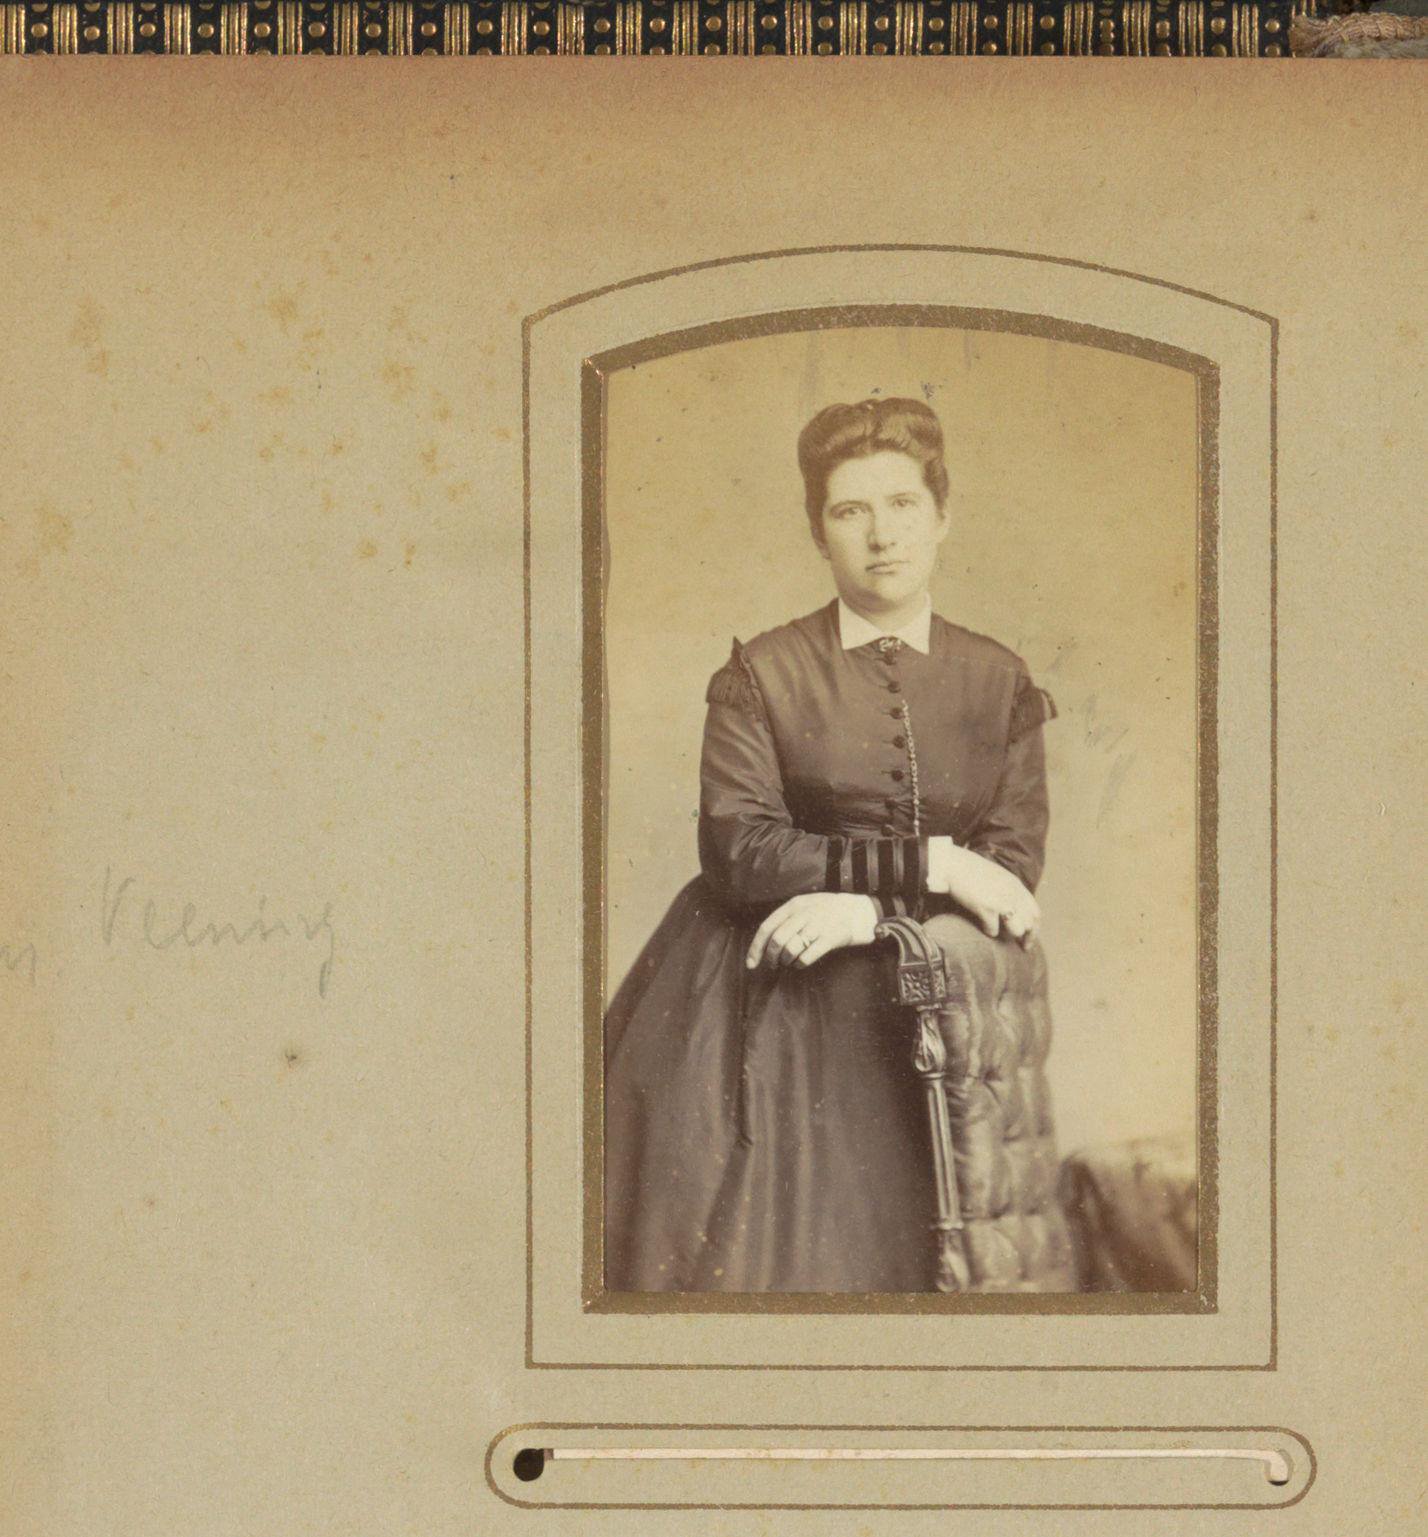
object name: photograph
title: Portret van een vrouw, [(...)] Veening geheten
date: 1865-1880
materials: cardboard, paper, photographic support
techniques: albumen print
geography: netherlands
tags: adult woman, studio requisites ~ photographer, historical persons - bb - woman, chair, netherlands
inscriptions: address: ‘Kalverstraat over den Heyligenweg D. 26 Amsterdam / Leydsche Straatweg Buiten Cathrynen Utrecht’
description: Onderdeel van Fotoalbum van de familie Boelen.